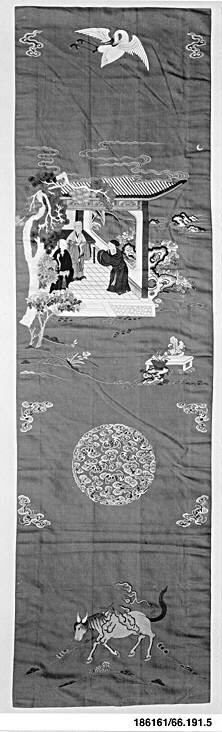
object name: chair strip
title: One of a Set of Twelve Chair Strips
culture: chinese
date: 1736-1795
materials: metal thread, silk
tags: human figures,animals,birds,trees